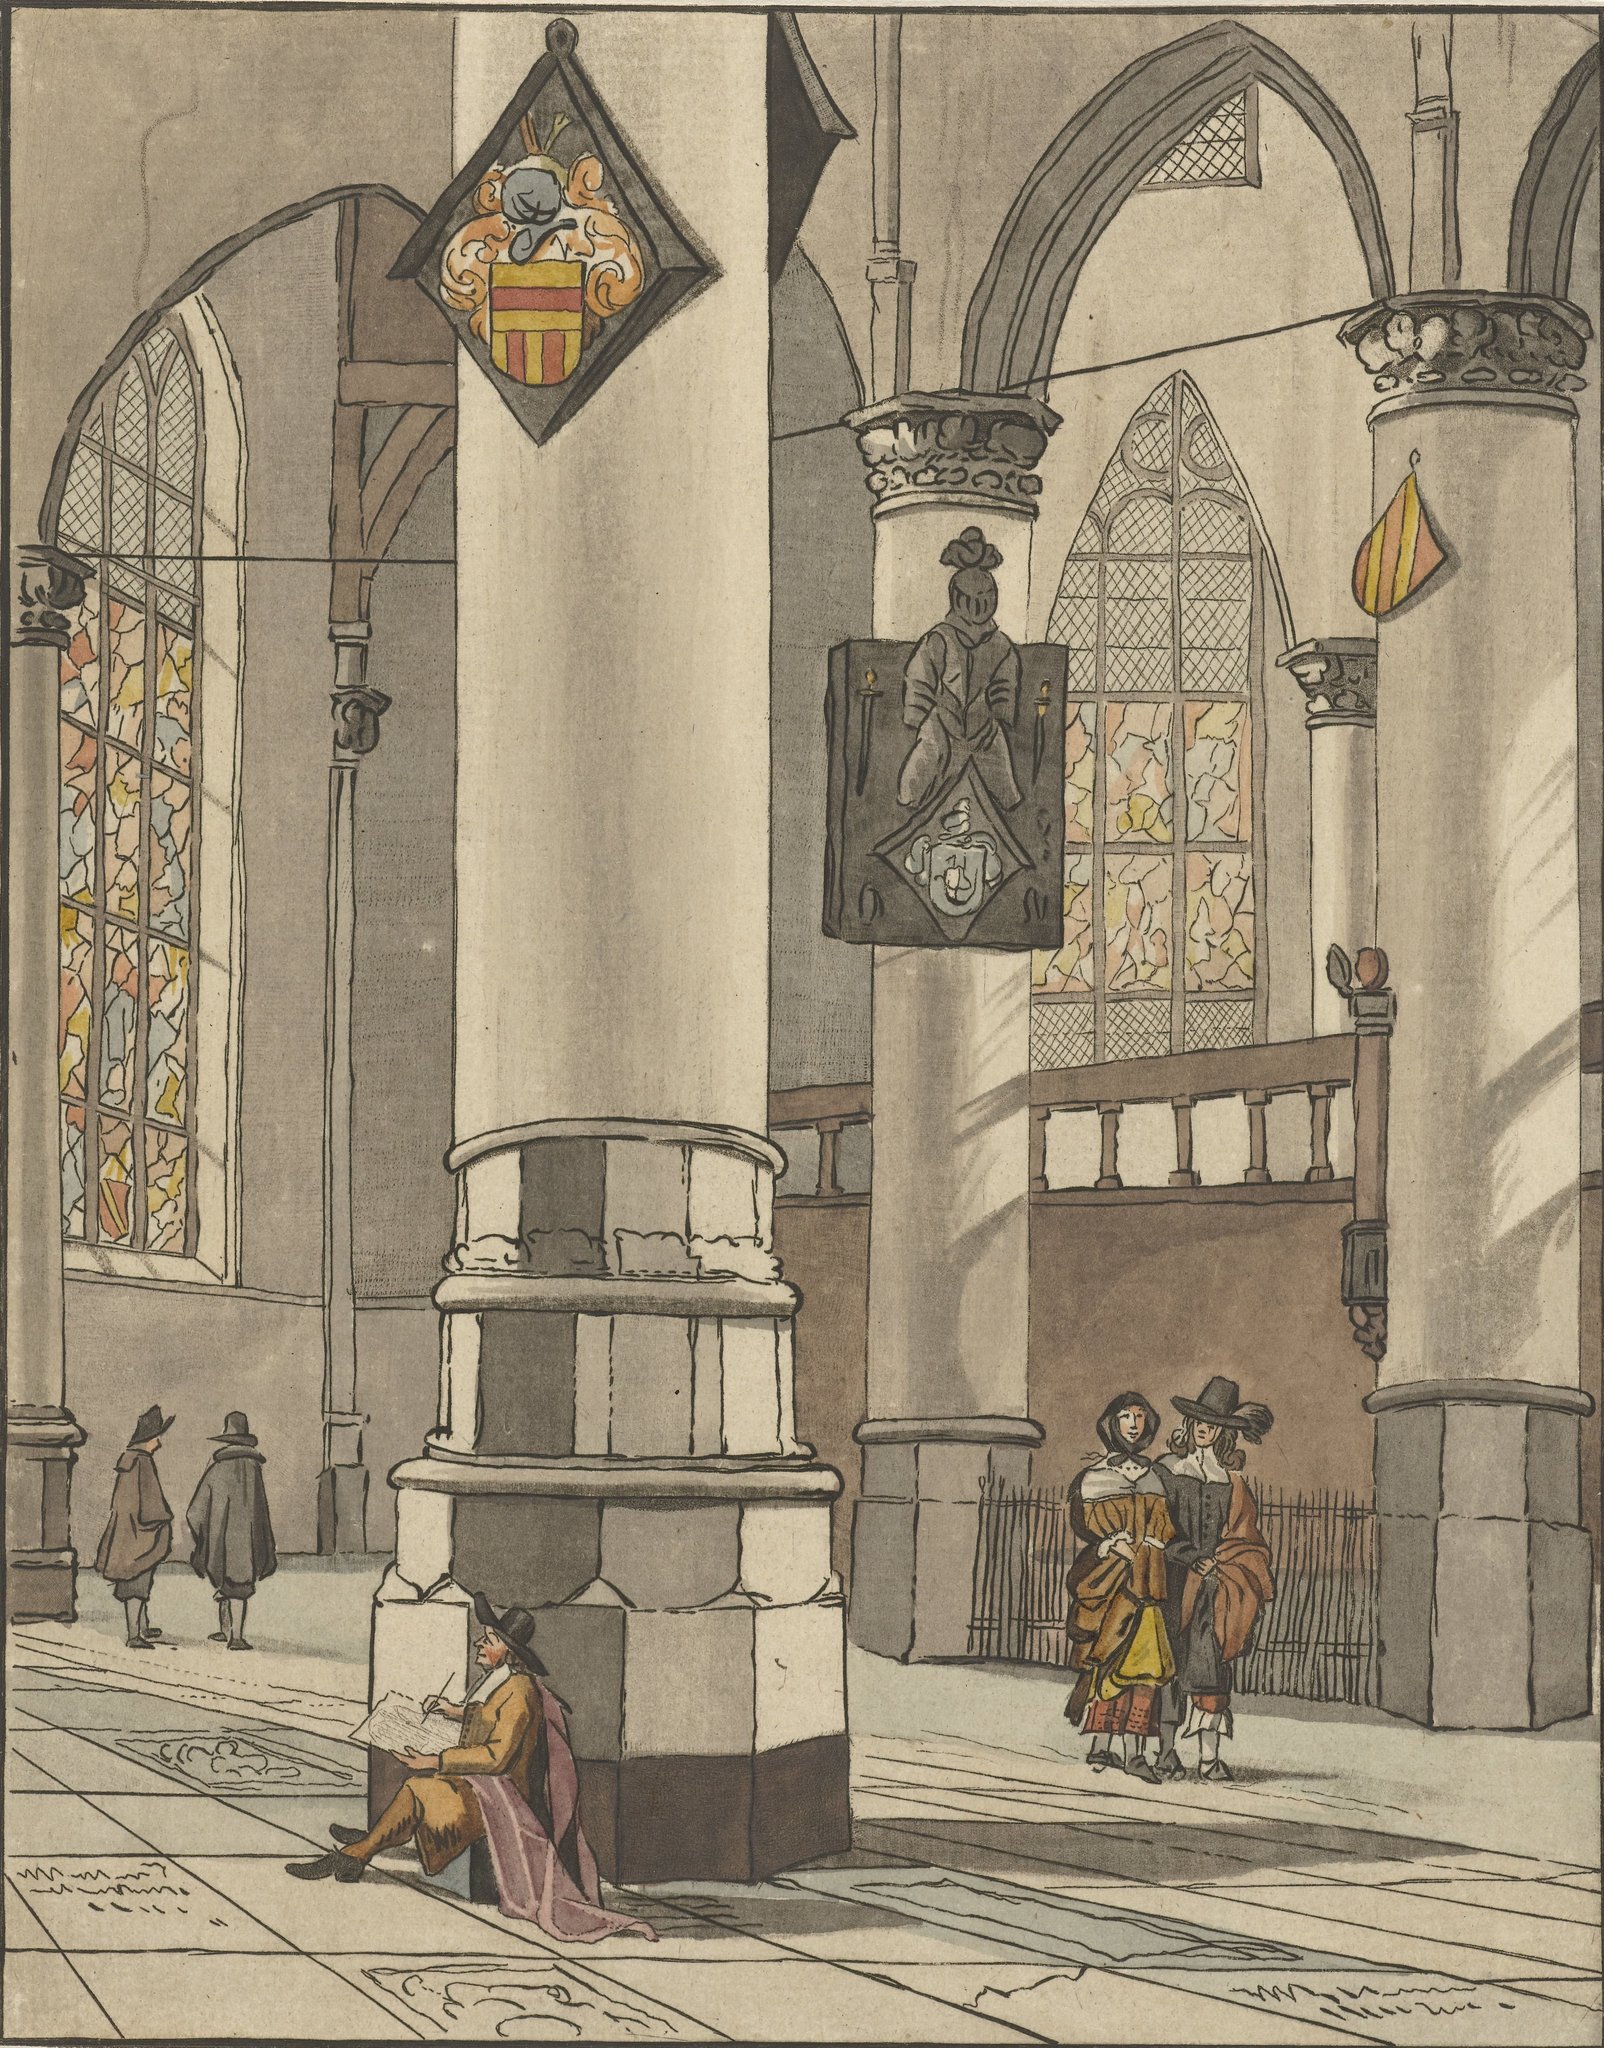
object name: print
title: Kerkinterieur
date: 1774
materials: paper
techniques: etching, hand coloring, roulette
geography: amsterdam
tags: interior of church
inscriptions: collector's mark: Lugt 240, collector's mark: Lugt 2725, inscription: ‘P. Saenredam. del. 1630. Ploos van Amstel. J.C. F: 1774.’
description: Interieur van een kerk. Aan de voet van een pilaar zit een kunstenaar te tekenen. Rechts lopen een gearmde man en een vrouw.